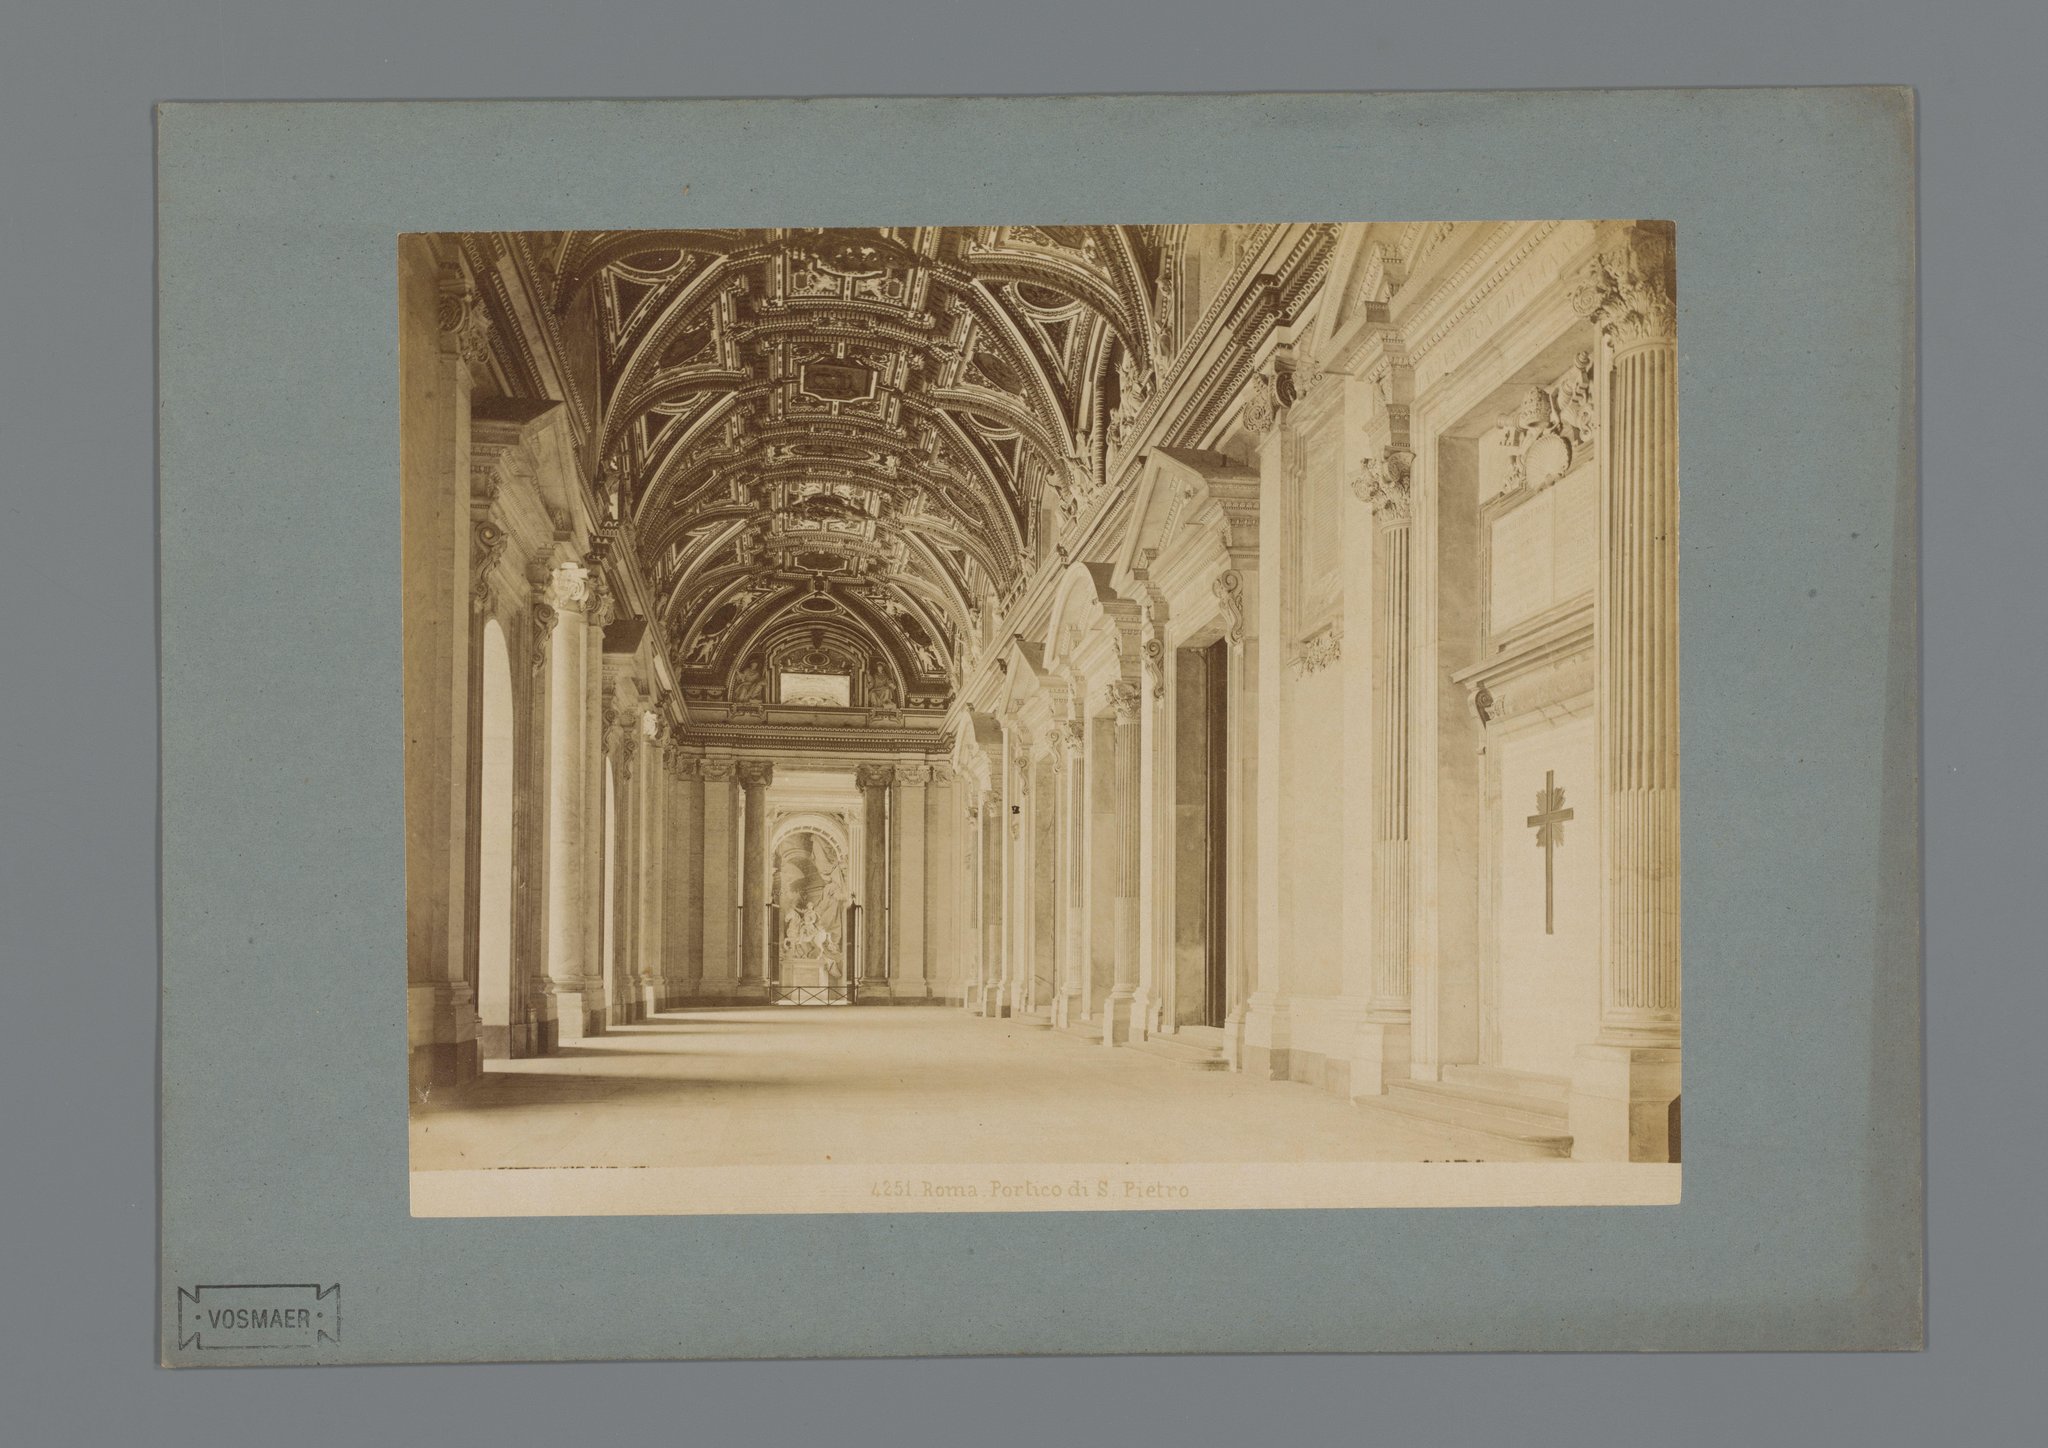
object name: photograph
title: Roma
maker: Anonymous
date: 1851-1890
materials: cardboard, paper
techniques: albumen print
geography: vatican city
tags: parts of church exterior and annexes: portal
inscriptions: collector's mark: ‘VOSMAER’, number: ‘4251.’